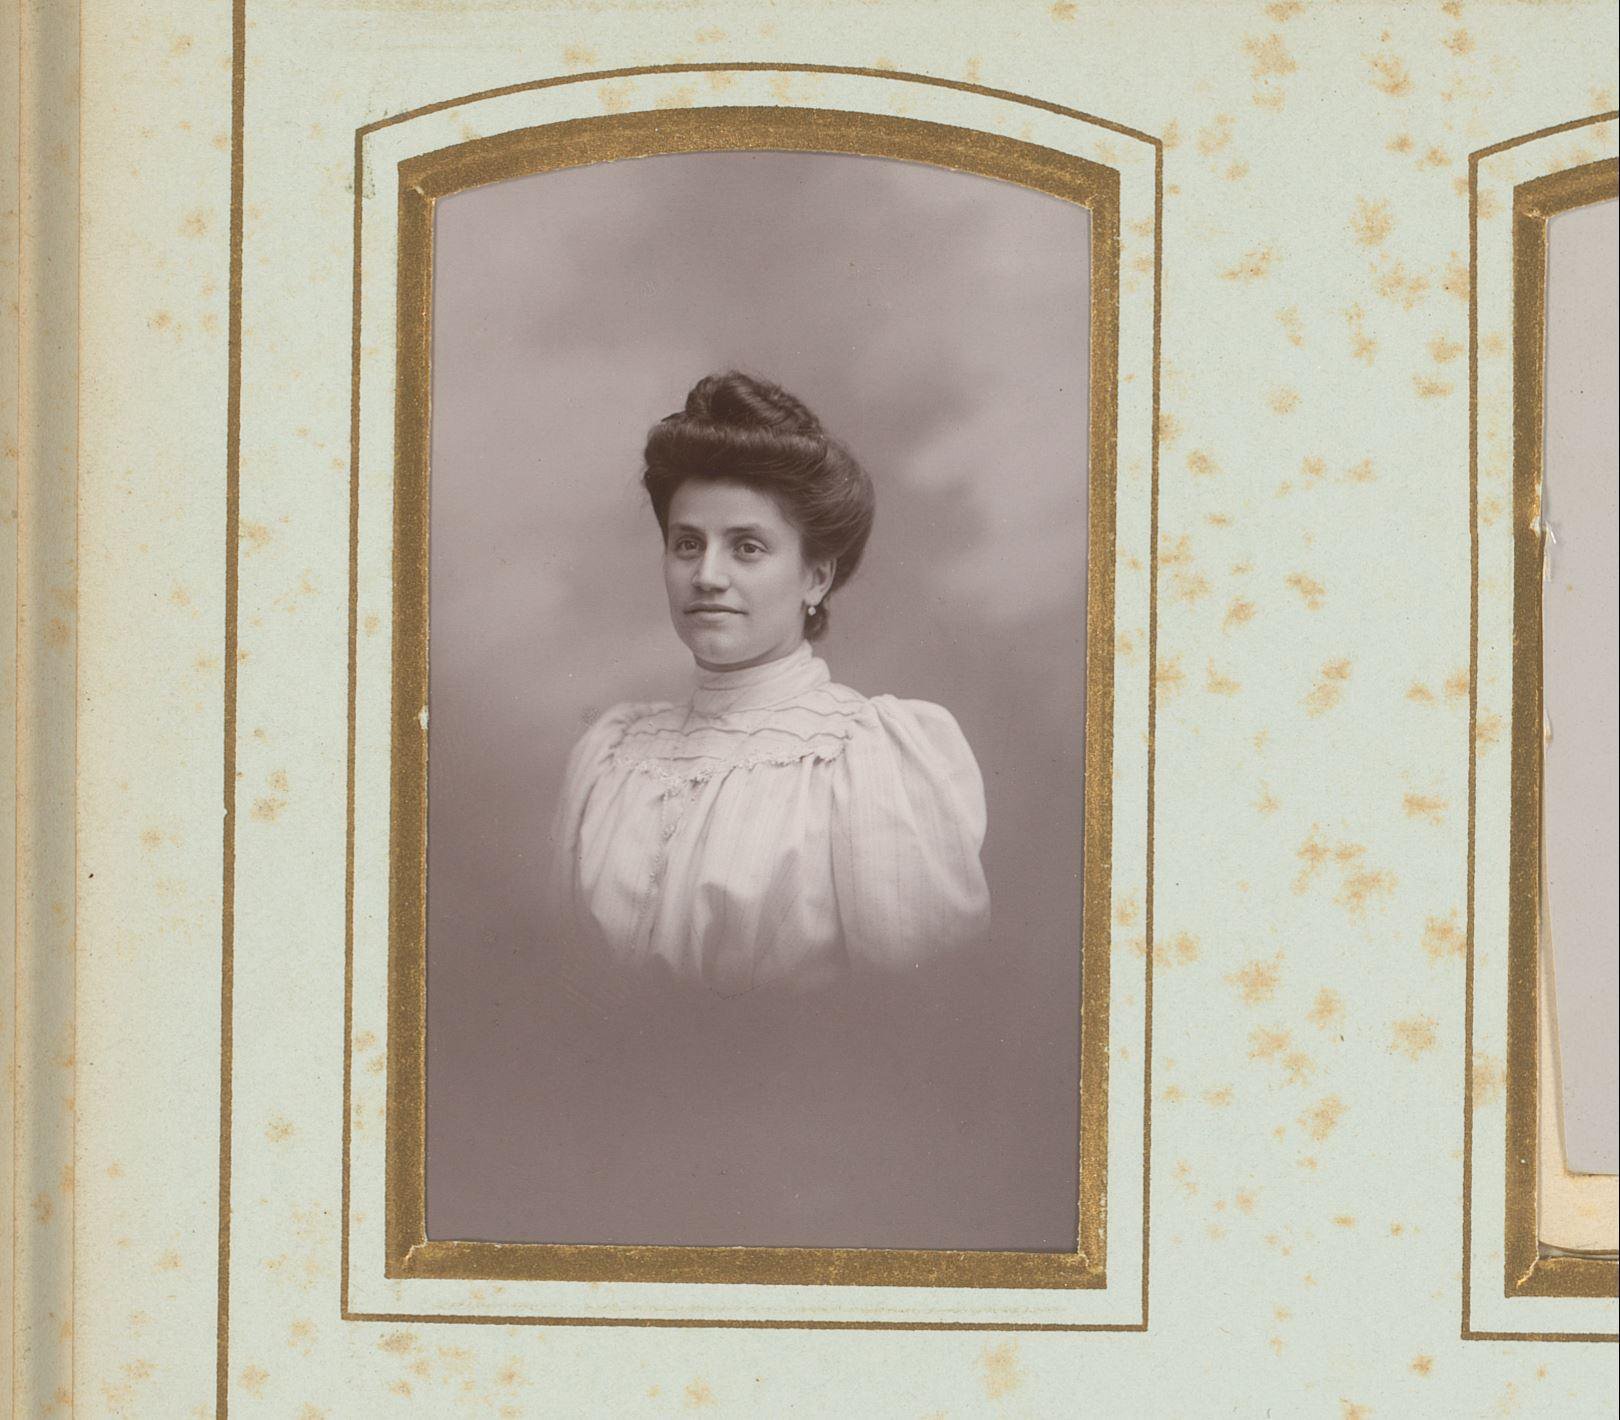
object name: album leaf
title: Groepsportret van een jonge vrouw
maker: Anonymous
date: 1880-1920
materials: cardboard, photographic support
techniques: collodion silver print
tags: adolescent, young woman, maiden, historical persons - bb - woman